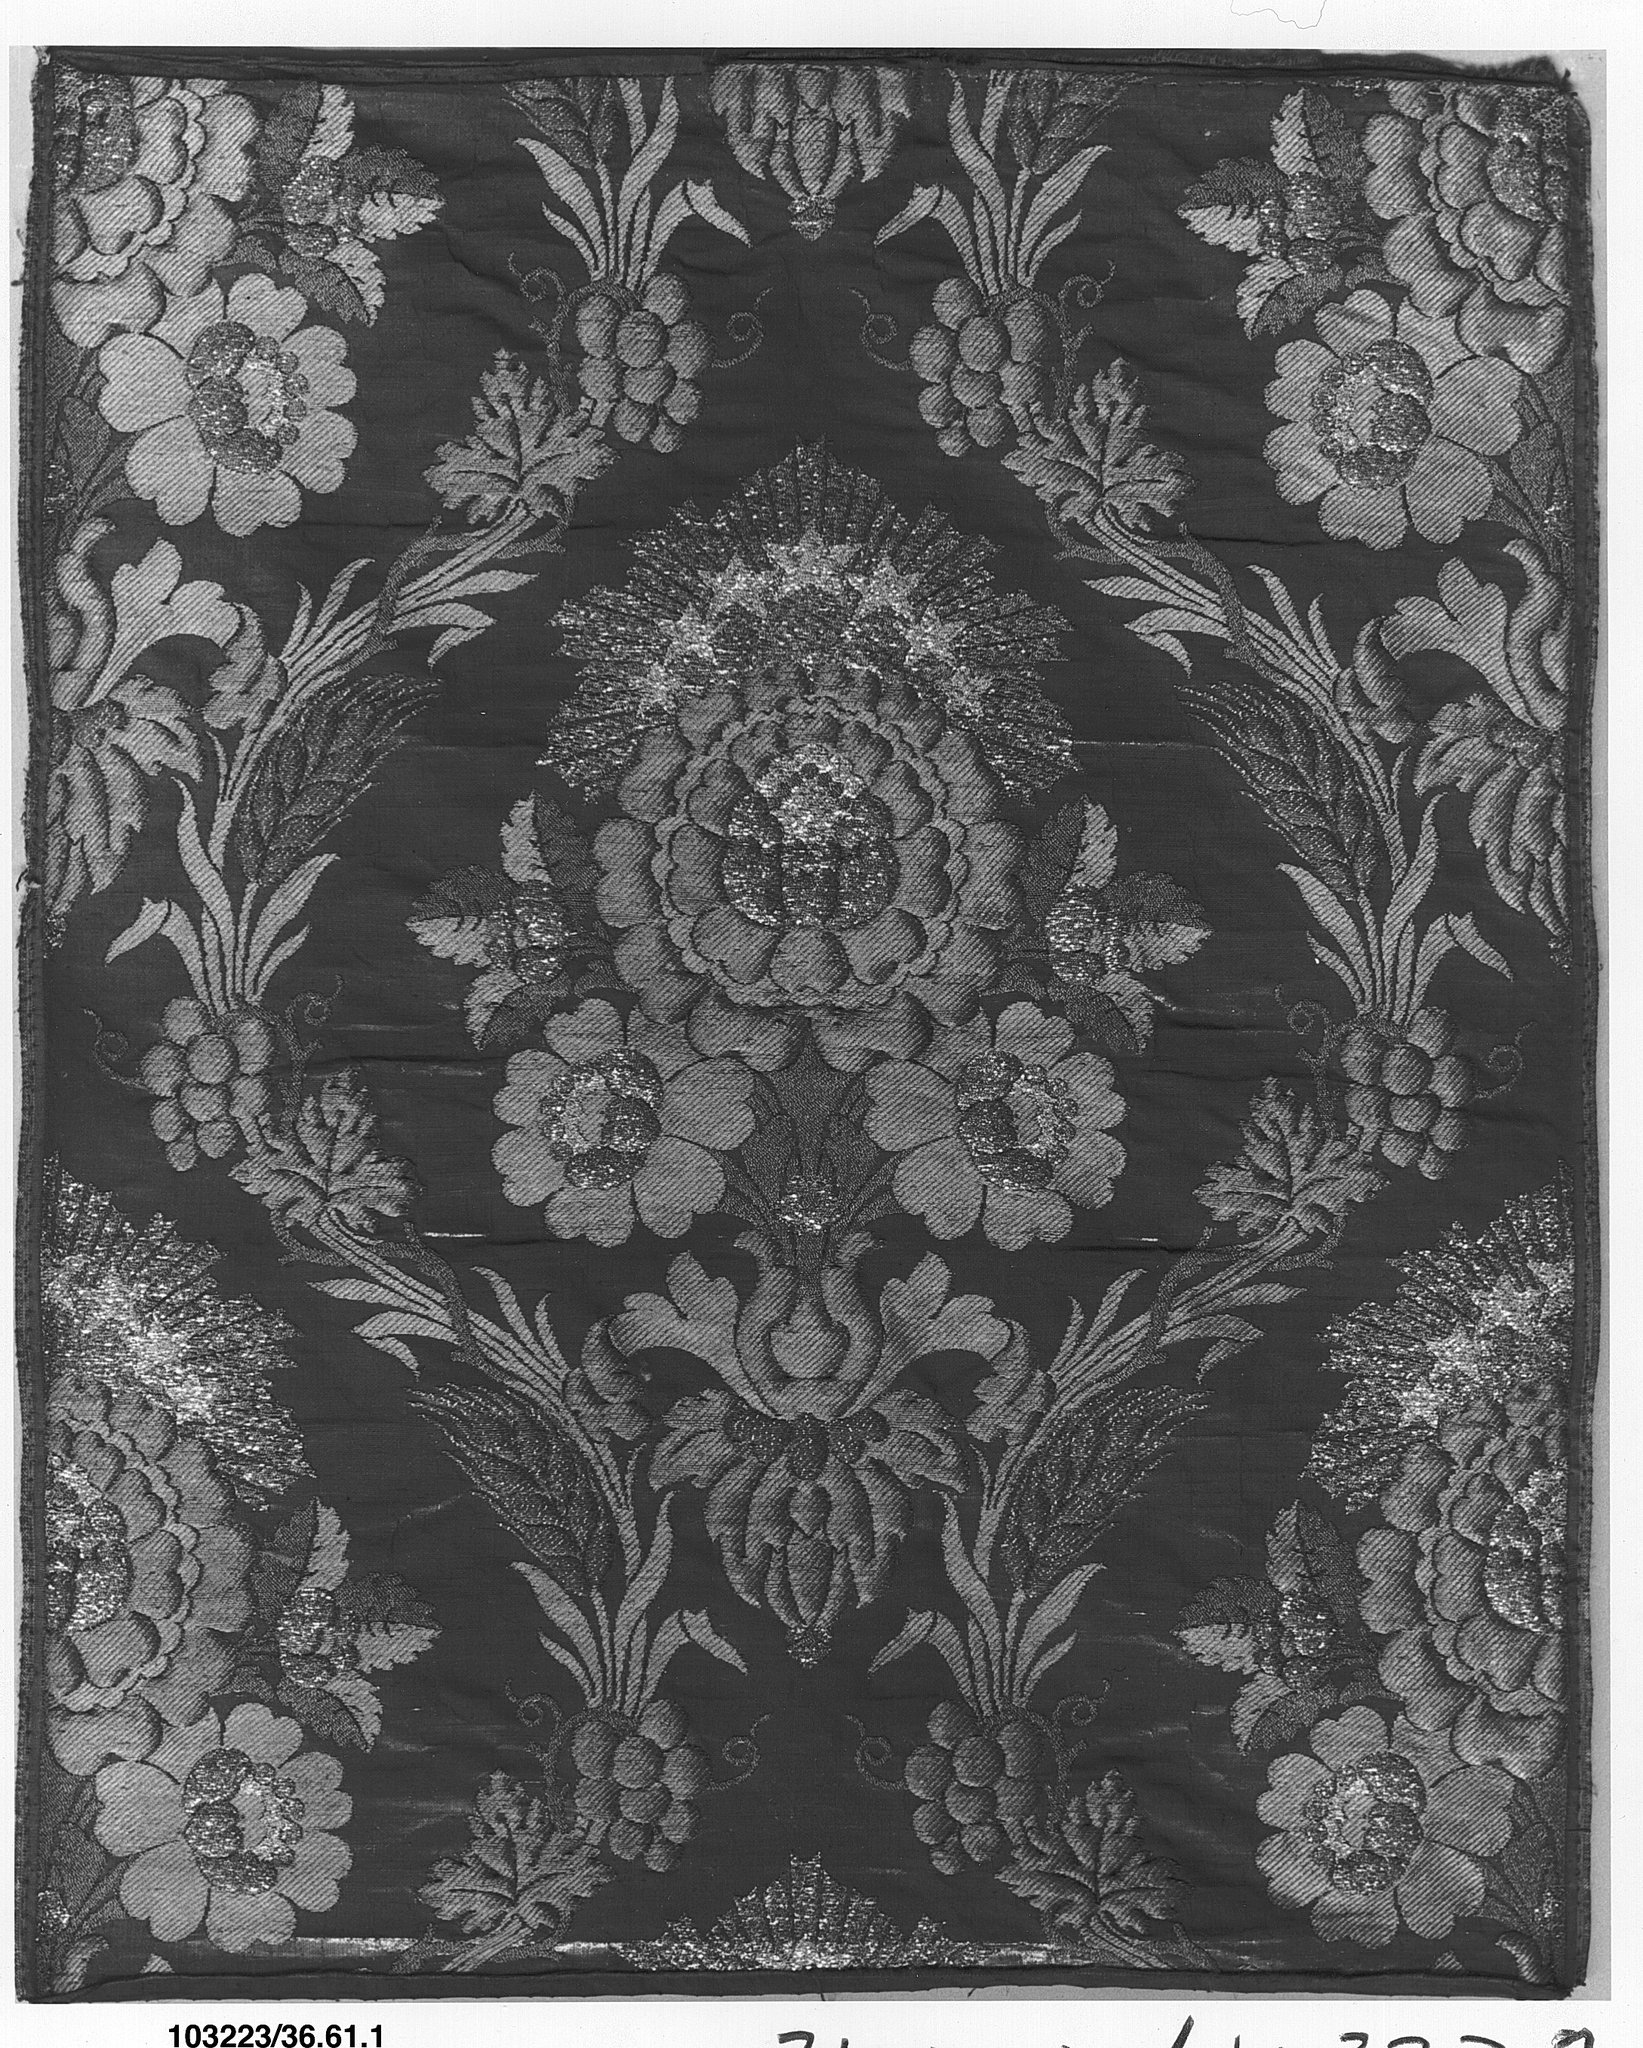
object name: piece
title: Pieces (2)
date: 1812-1820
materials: linen, metal thread, silk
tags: flowers,leaves